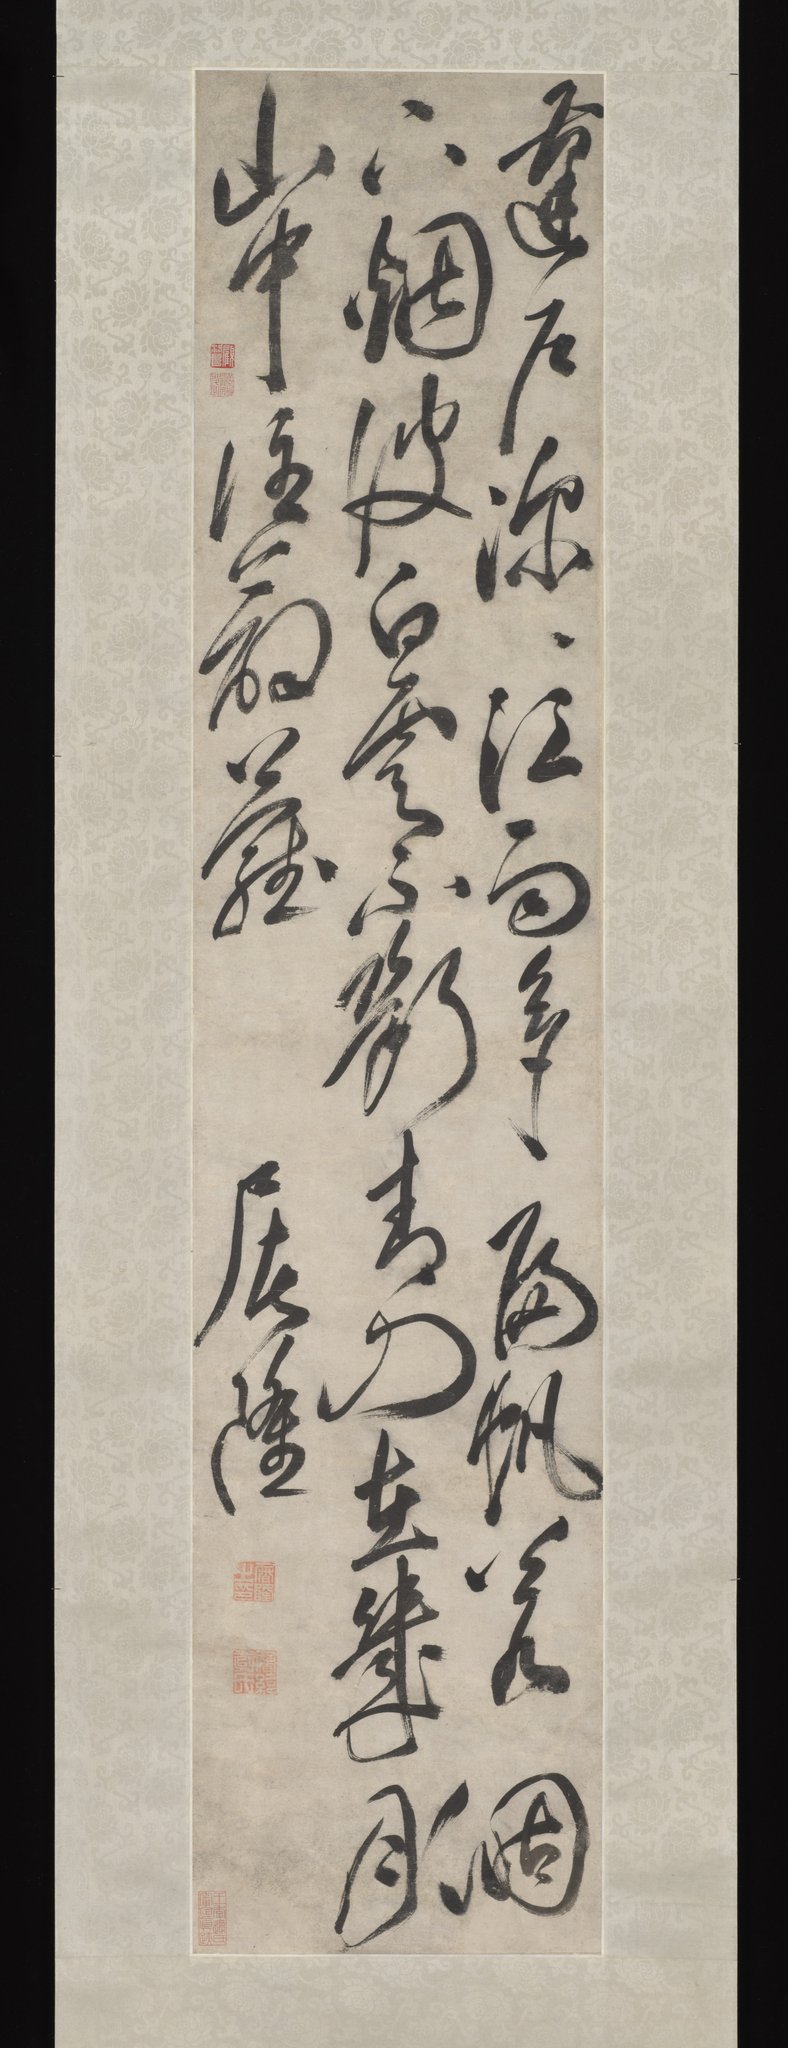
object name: hanging scroll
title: Poem on a hermitage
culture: chinese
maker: tu long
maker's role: artist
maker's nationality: chinese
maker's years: 1542-1605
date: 1567-1600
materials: ink, paper